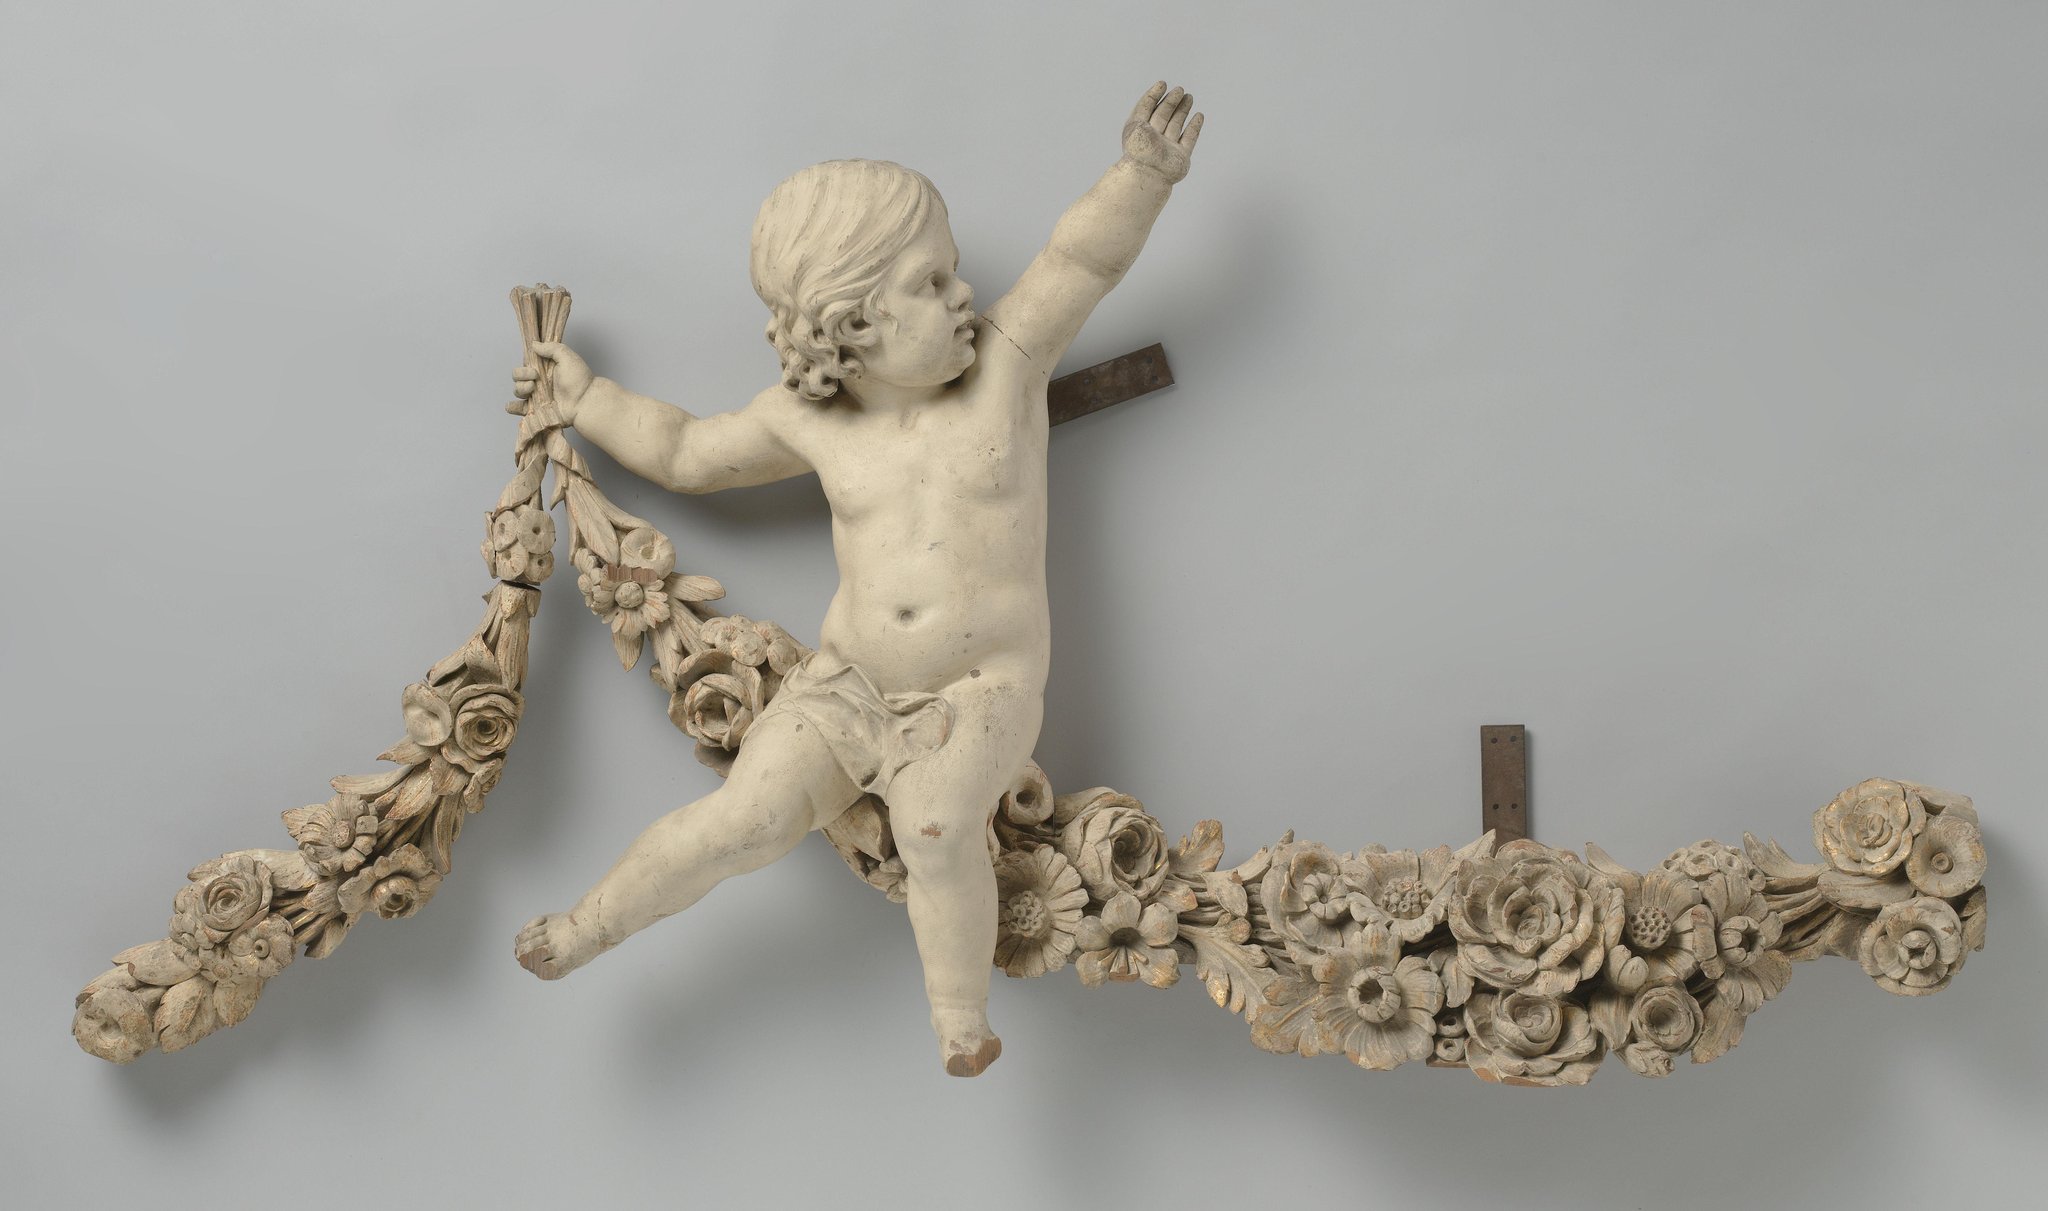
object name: sculpture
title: A Child on a Garland of Flowers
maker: michiel emanuel shee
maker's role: sculptor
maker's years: -1740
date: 1727-1739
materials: wood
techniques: painted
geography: amsterdam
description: De vier elementen, voorgesteld door twee groepen van twee naar elkaar toegewende putti (BK-1957-24-A & B), die tussen hen in bloemenguirlandes houden, waarvan de einden omlaag hangen. Slechts één putto aanwezig. De tweede ontbreekt, evenals een deel van de guirlande.